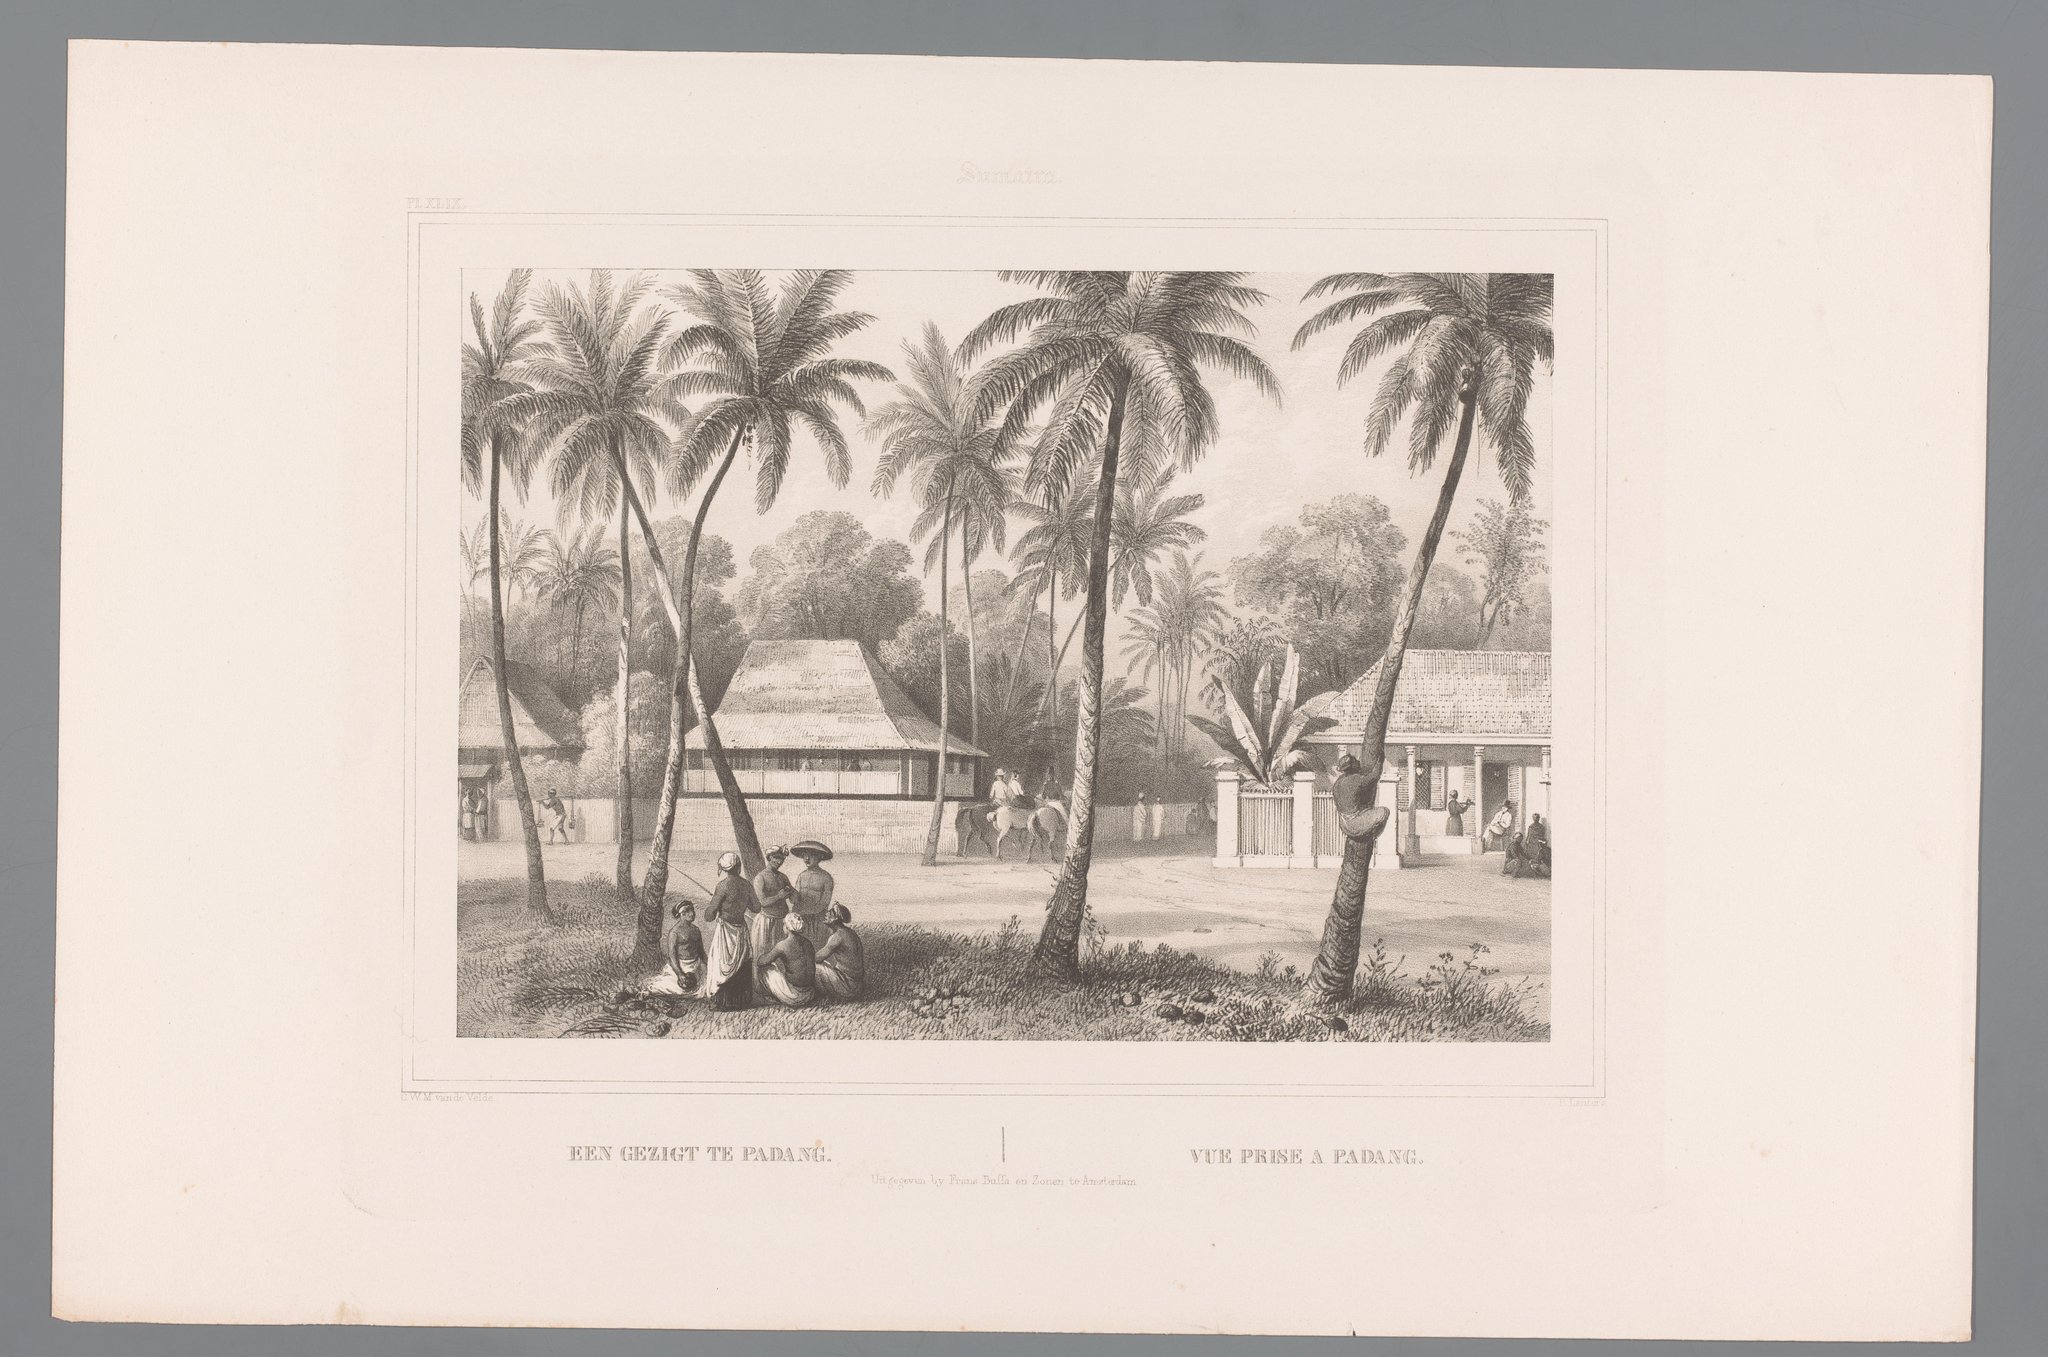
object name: print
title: Gezigten uit Neêrlands Indië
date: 1847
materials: paper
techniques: lithograph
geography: amsterdam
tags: street, climbing up a tree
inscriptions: collector's mark: Lugt 2228